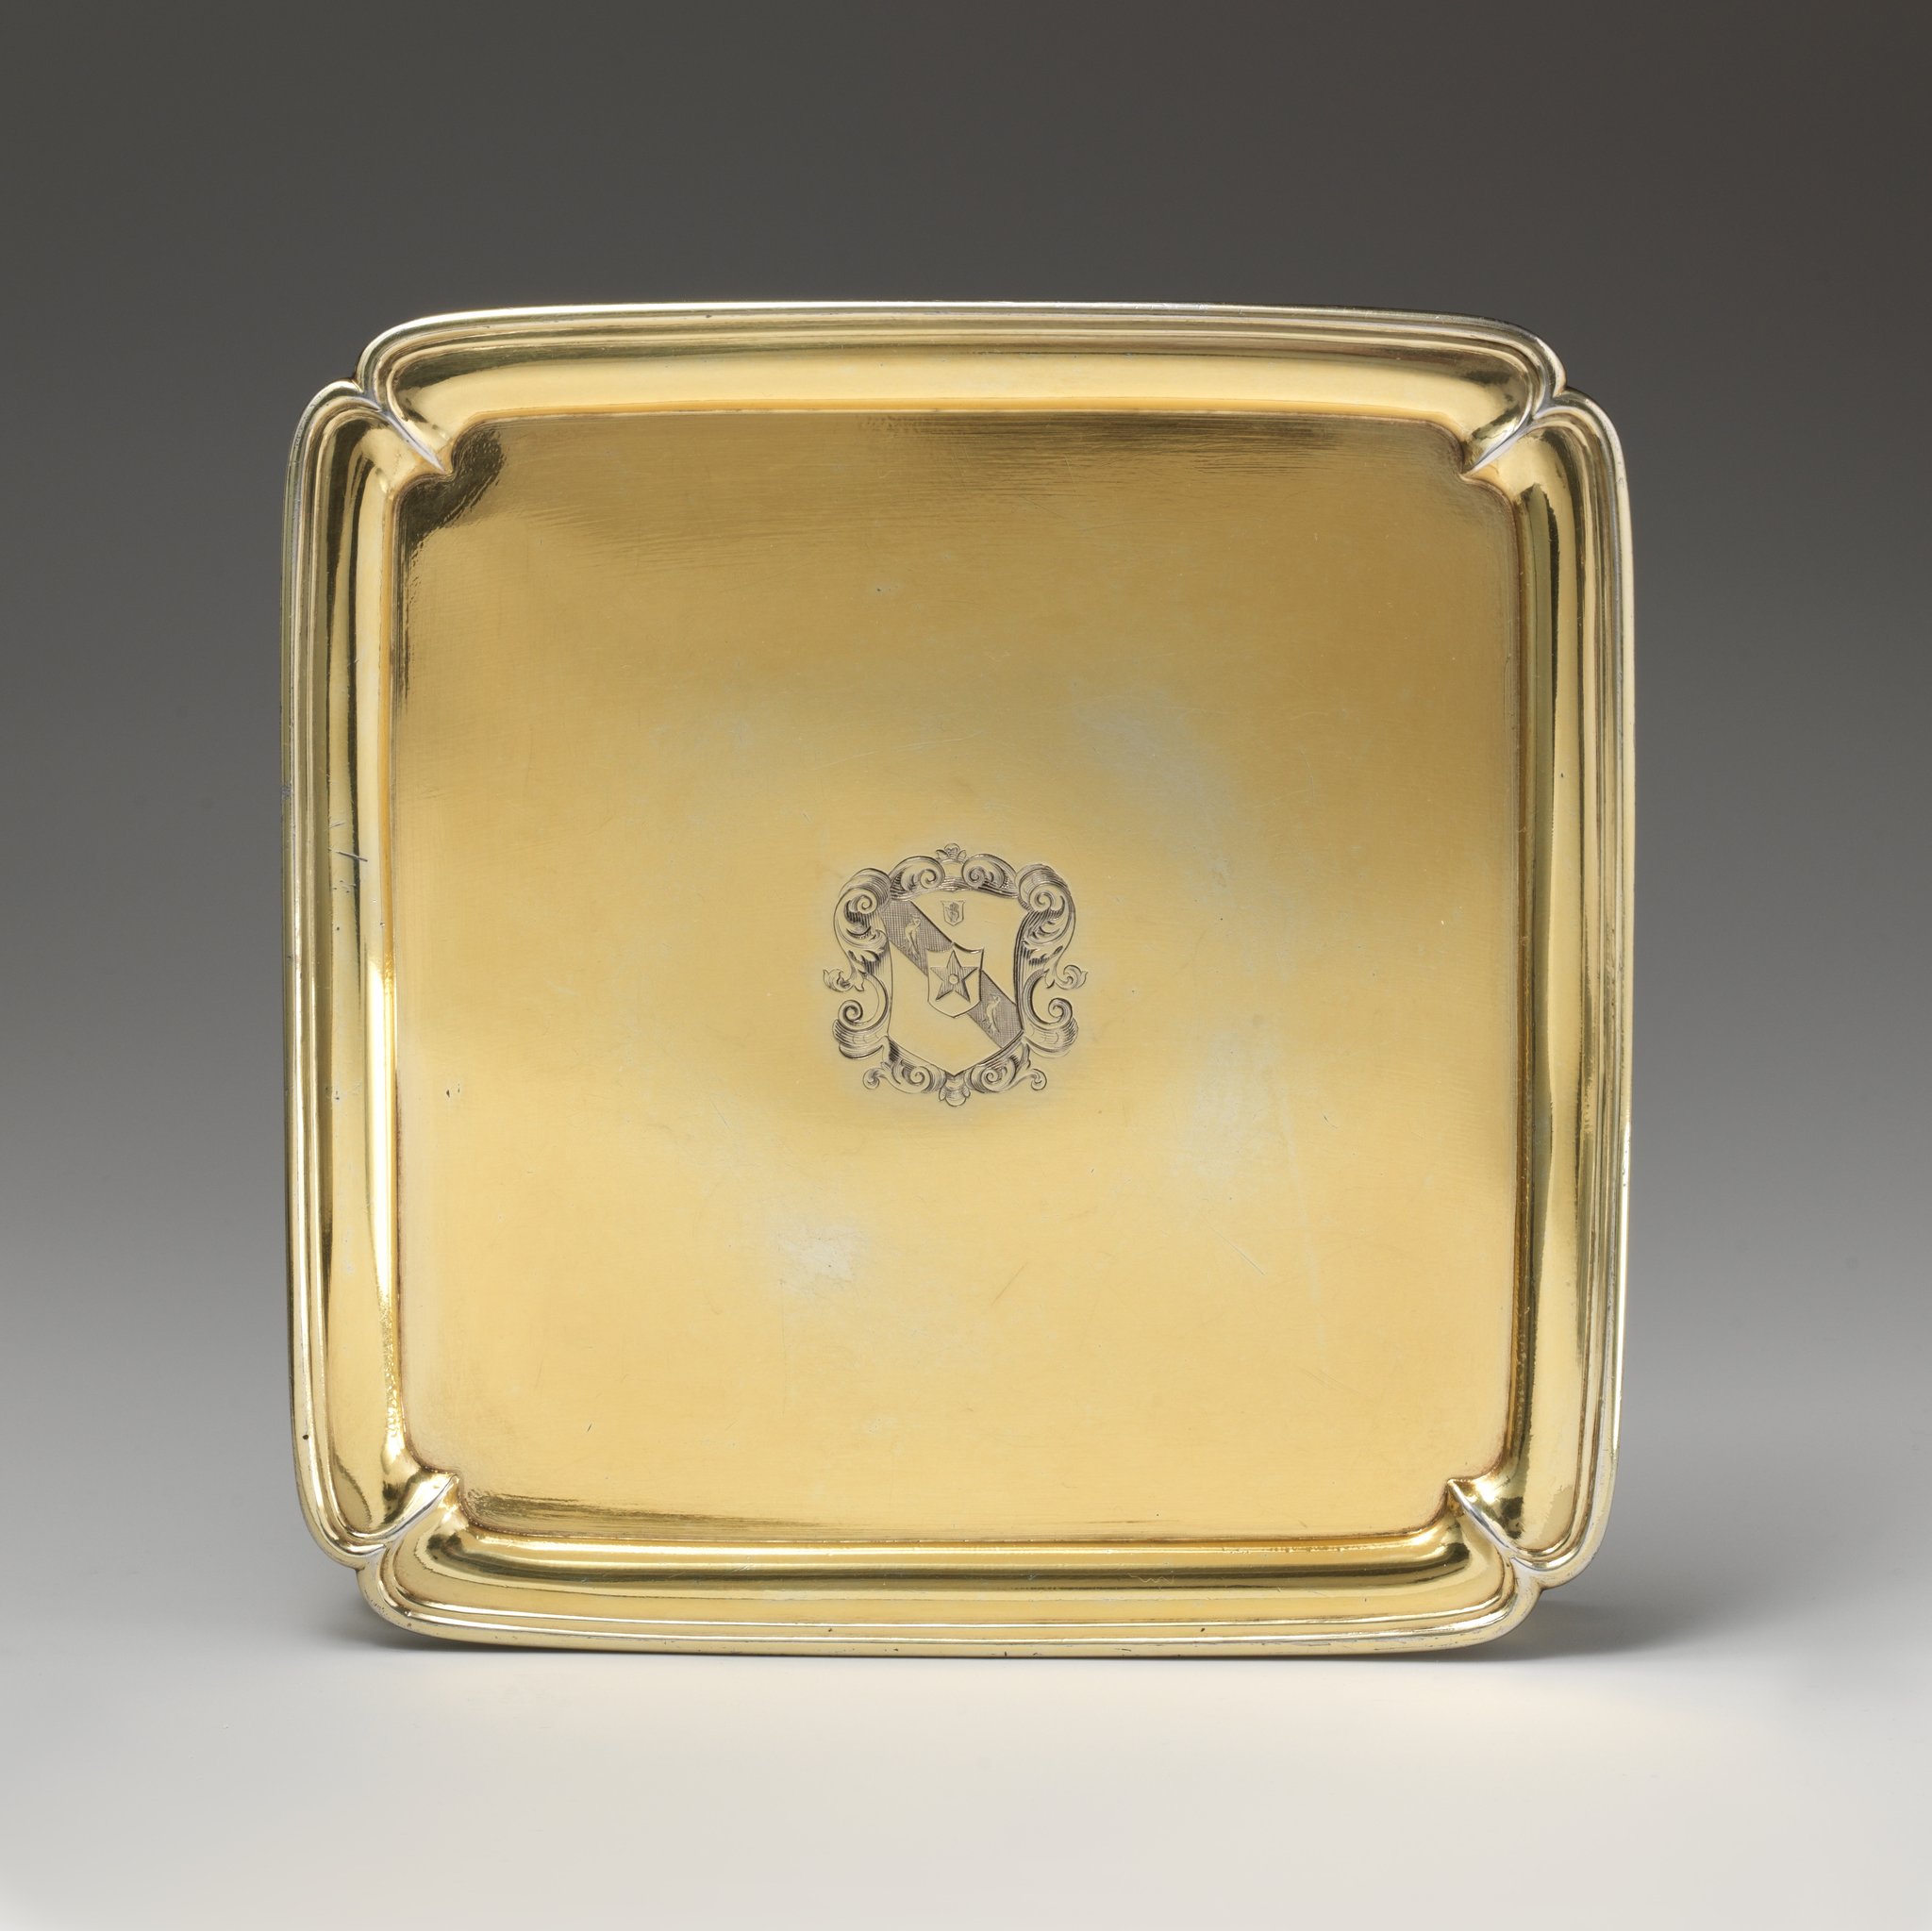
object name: salver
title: Salver (one of a pair)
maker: simon pantin i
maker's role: maker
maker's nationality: british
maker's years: 1672-1728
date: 1727-1728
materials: silver gilt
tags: coat of arms